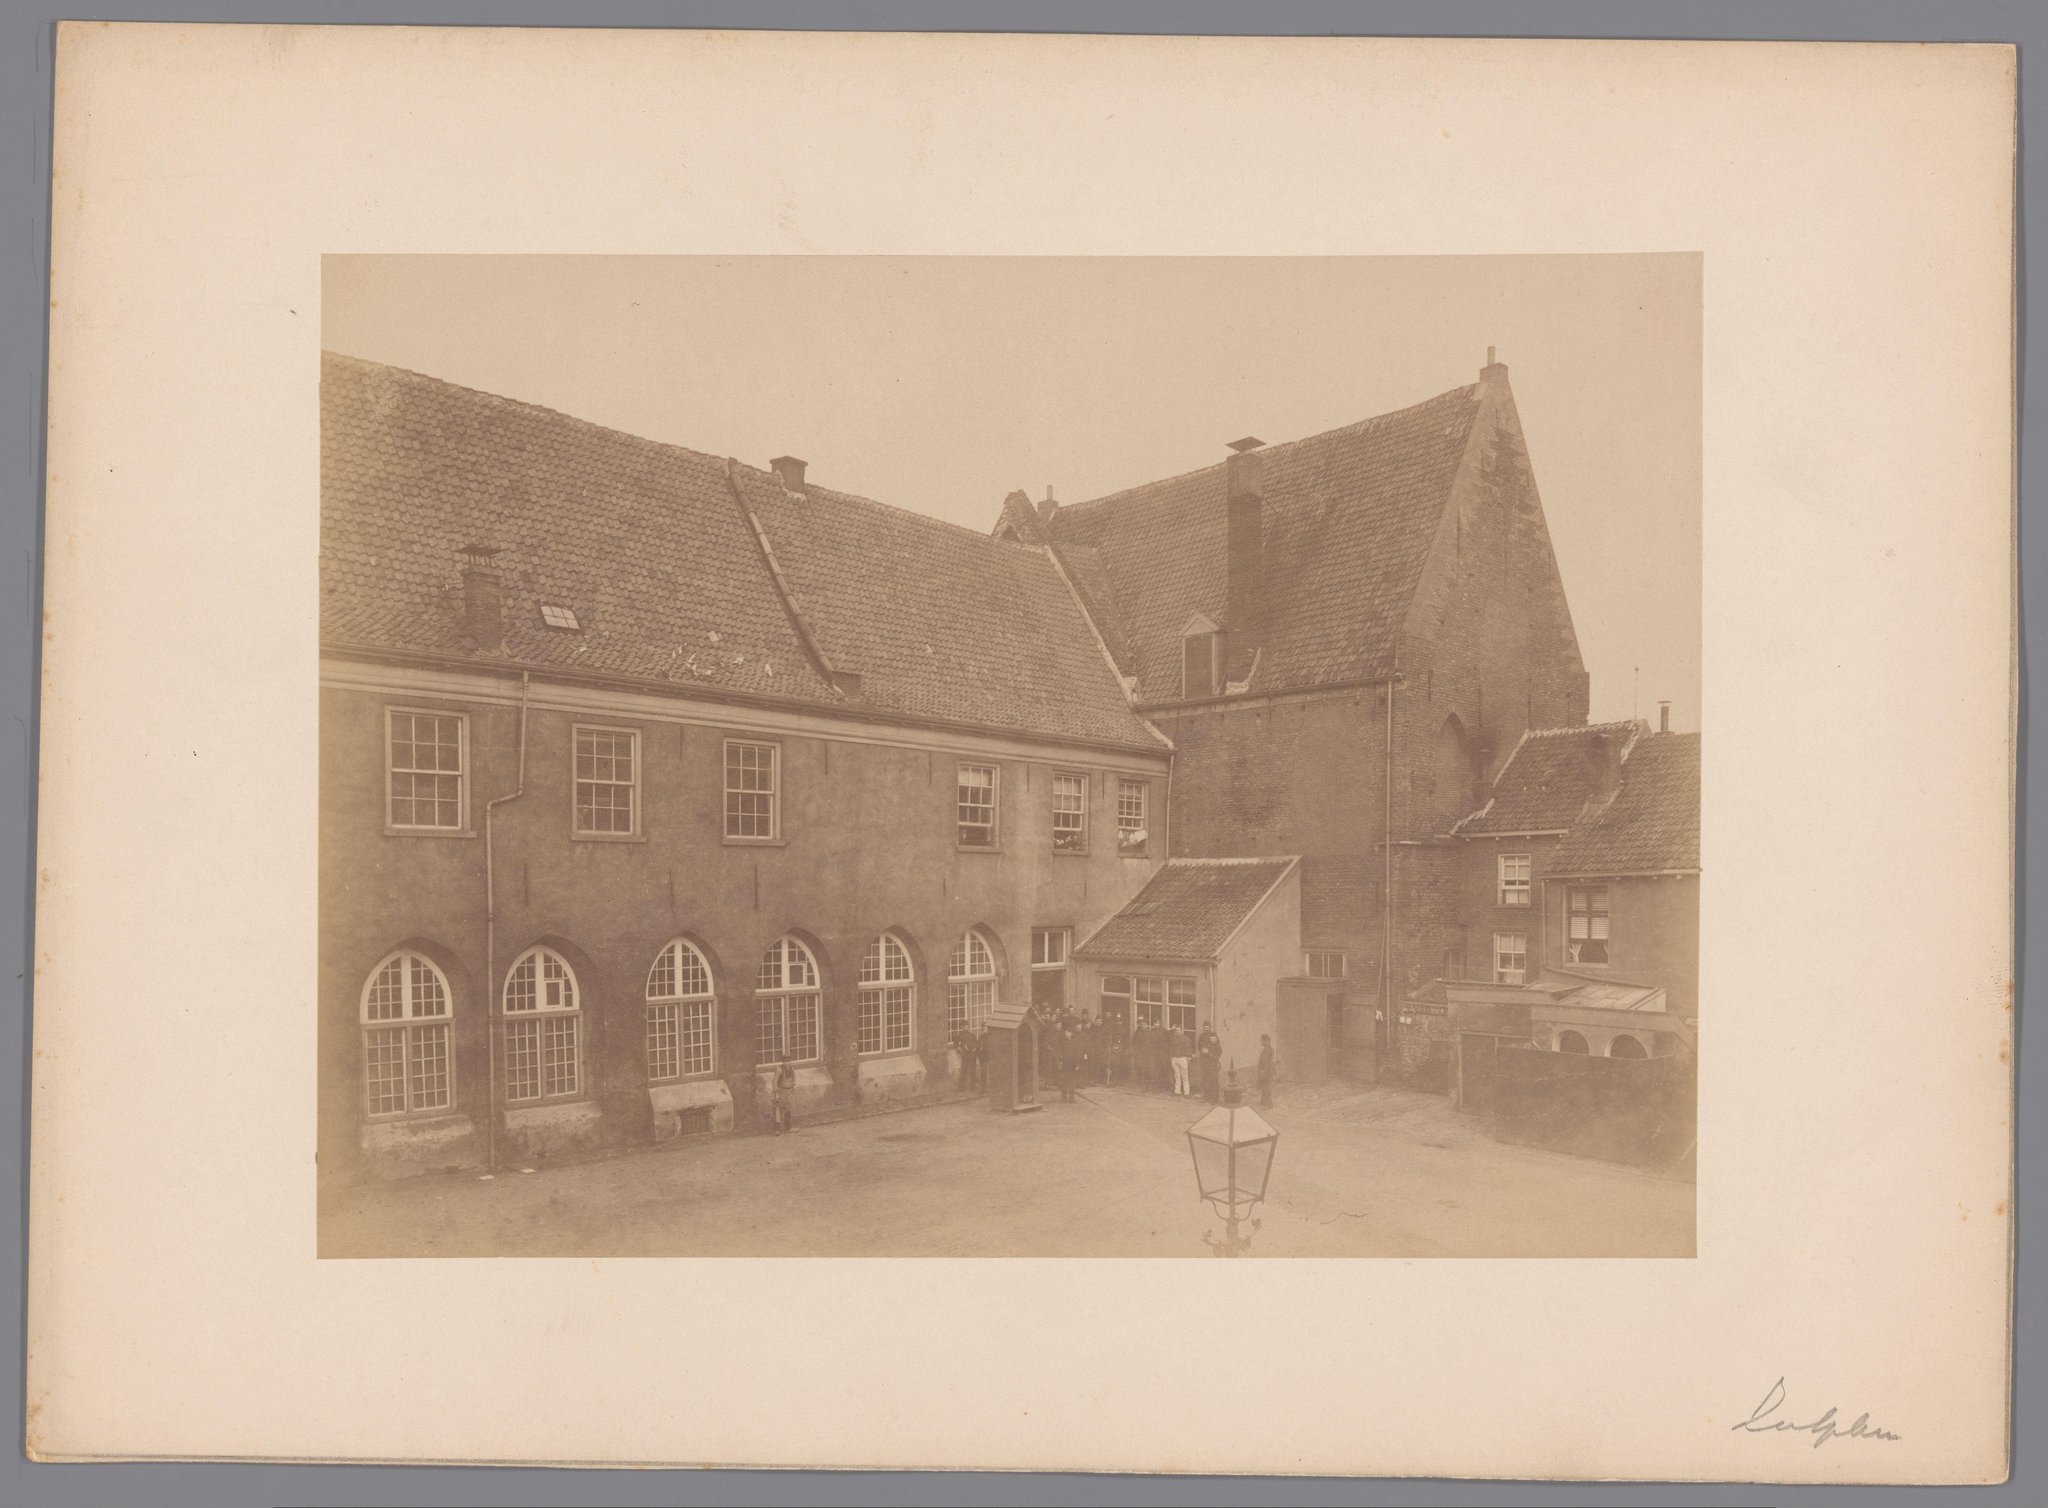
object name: photograph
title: Gezicht op de Broerenkazerne te Zutphen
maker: anoniem (monumentenzorg)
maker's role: fotograaf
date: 1895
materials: cardboard, photographic support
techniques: albumen print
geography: zutphen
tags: barracks, street (+ city(-scape) with figures, staffage)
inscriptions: annotation: ‘Zutphen’, annotation: ‘Broerenkaserne te Zutphen (G.)/ Nov 1895’